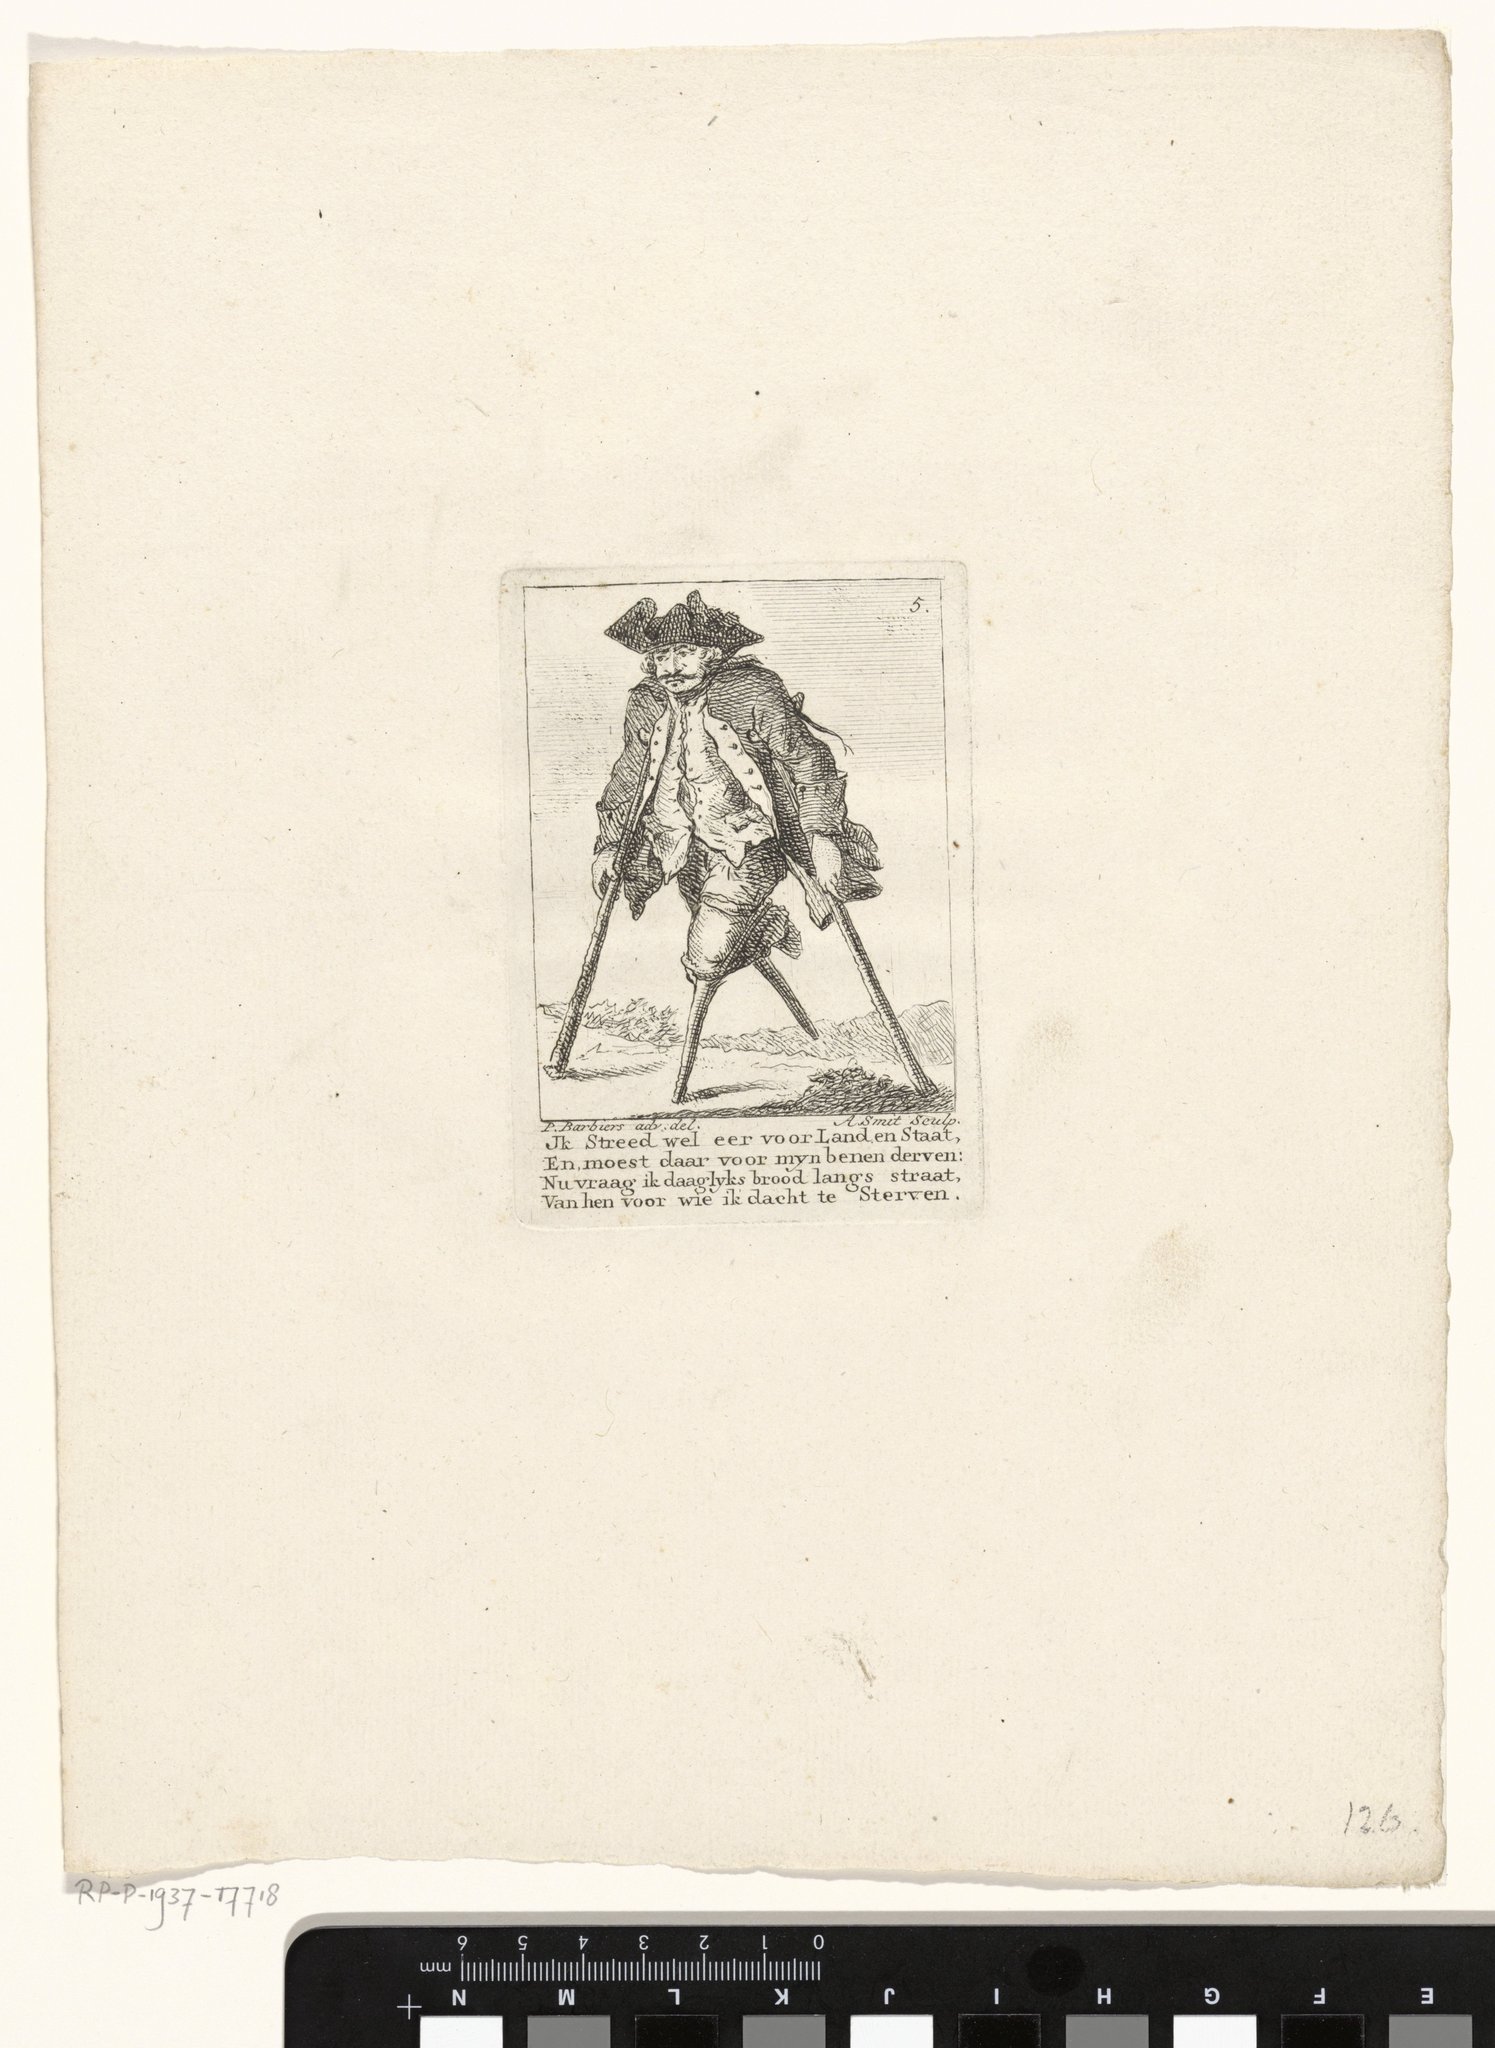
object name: print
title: Bedelaar op krukken en twee houten benen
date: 1764-1792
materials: paper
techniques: engraving, etching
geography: amsterdam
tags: crutches, wooden leg, beggar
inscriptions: collector's mark: Lugt 2228, collector's mark: ‘PvdV 125’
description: Een bedelaar op krukken met twee houten benen. Zijn benen verloor hij blijkens het versje onder de prent in de oorlog, strijdend voor het vaderland.